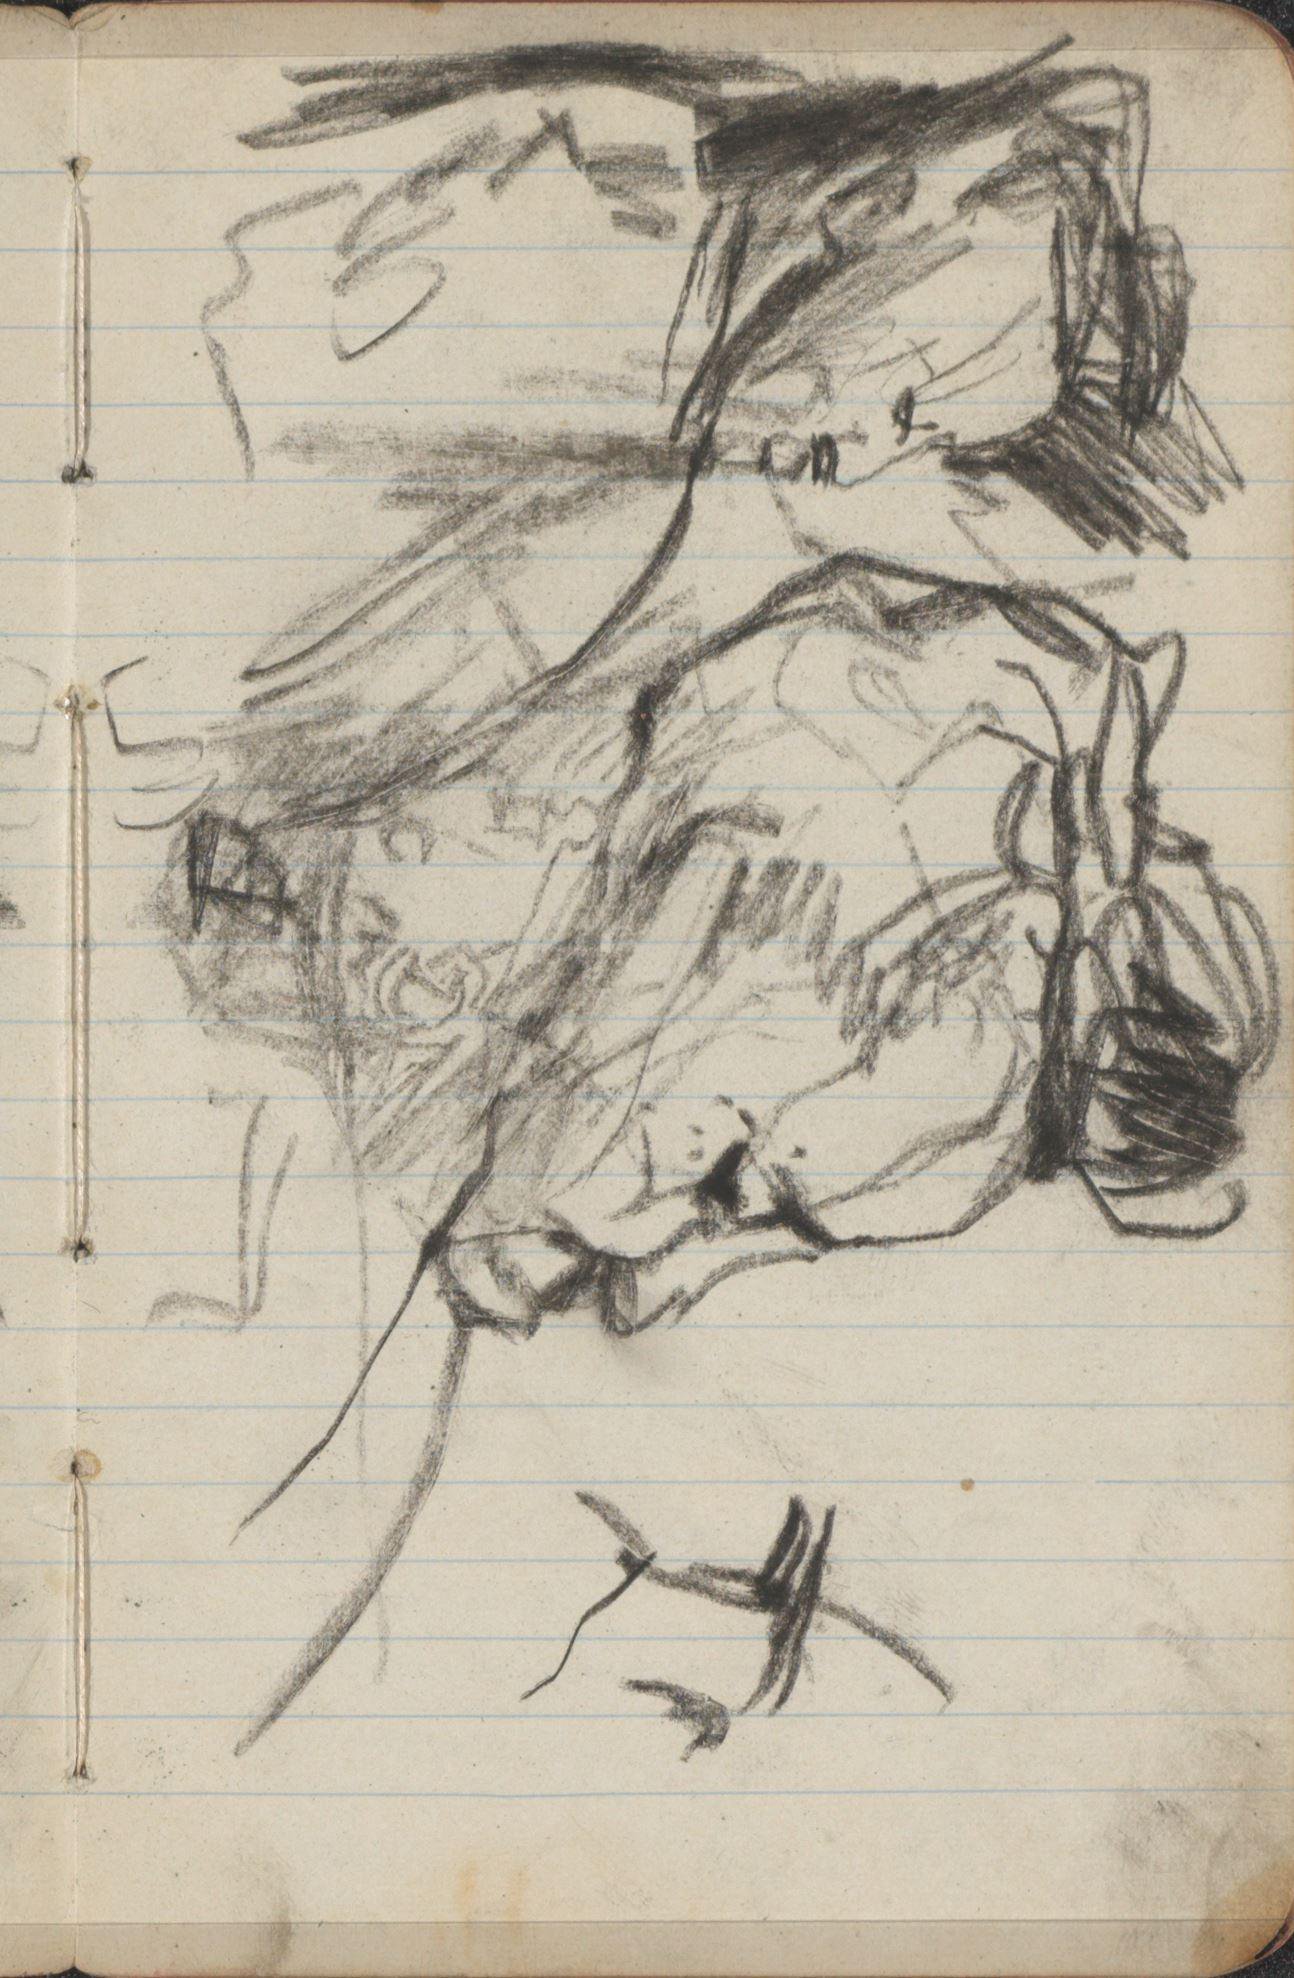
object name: sketchbook leaf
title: Oude vrouwen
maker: george hendrik breitner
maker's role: draughtsman, painter, print maker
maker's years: 1857-1923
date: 1894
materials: chalk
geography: amsterdam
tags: old woman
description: Pagina 10 uit een schetsboek met 31 bladen.